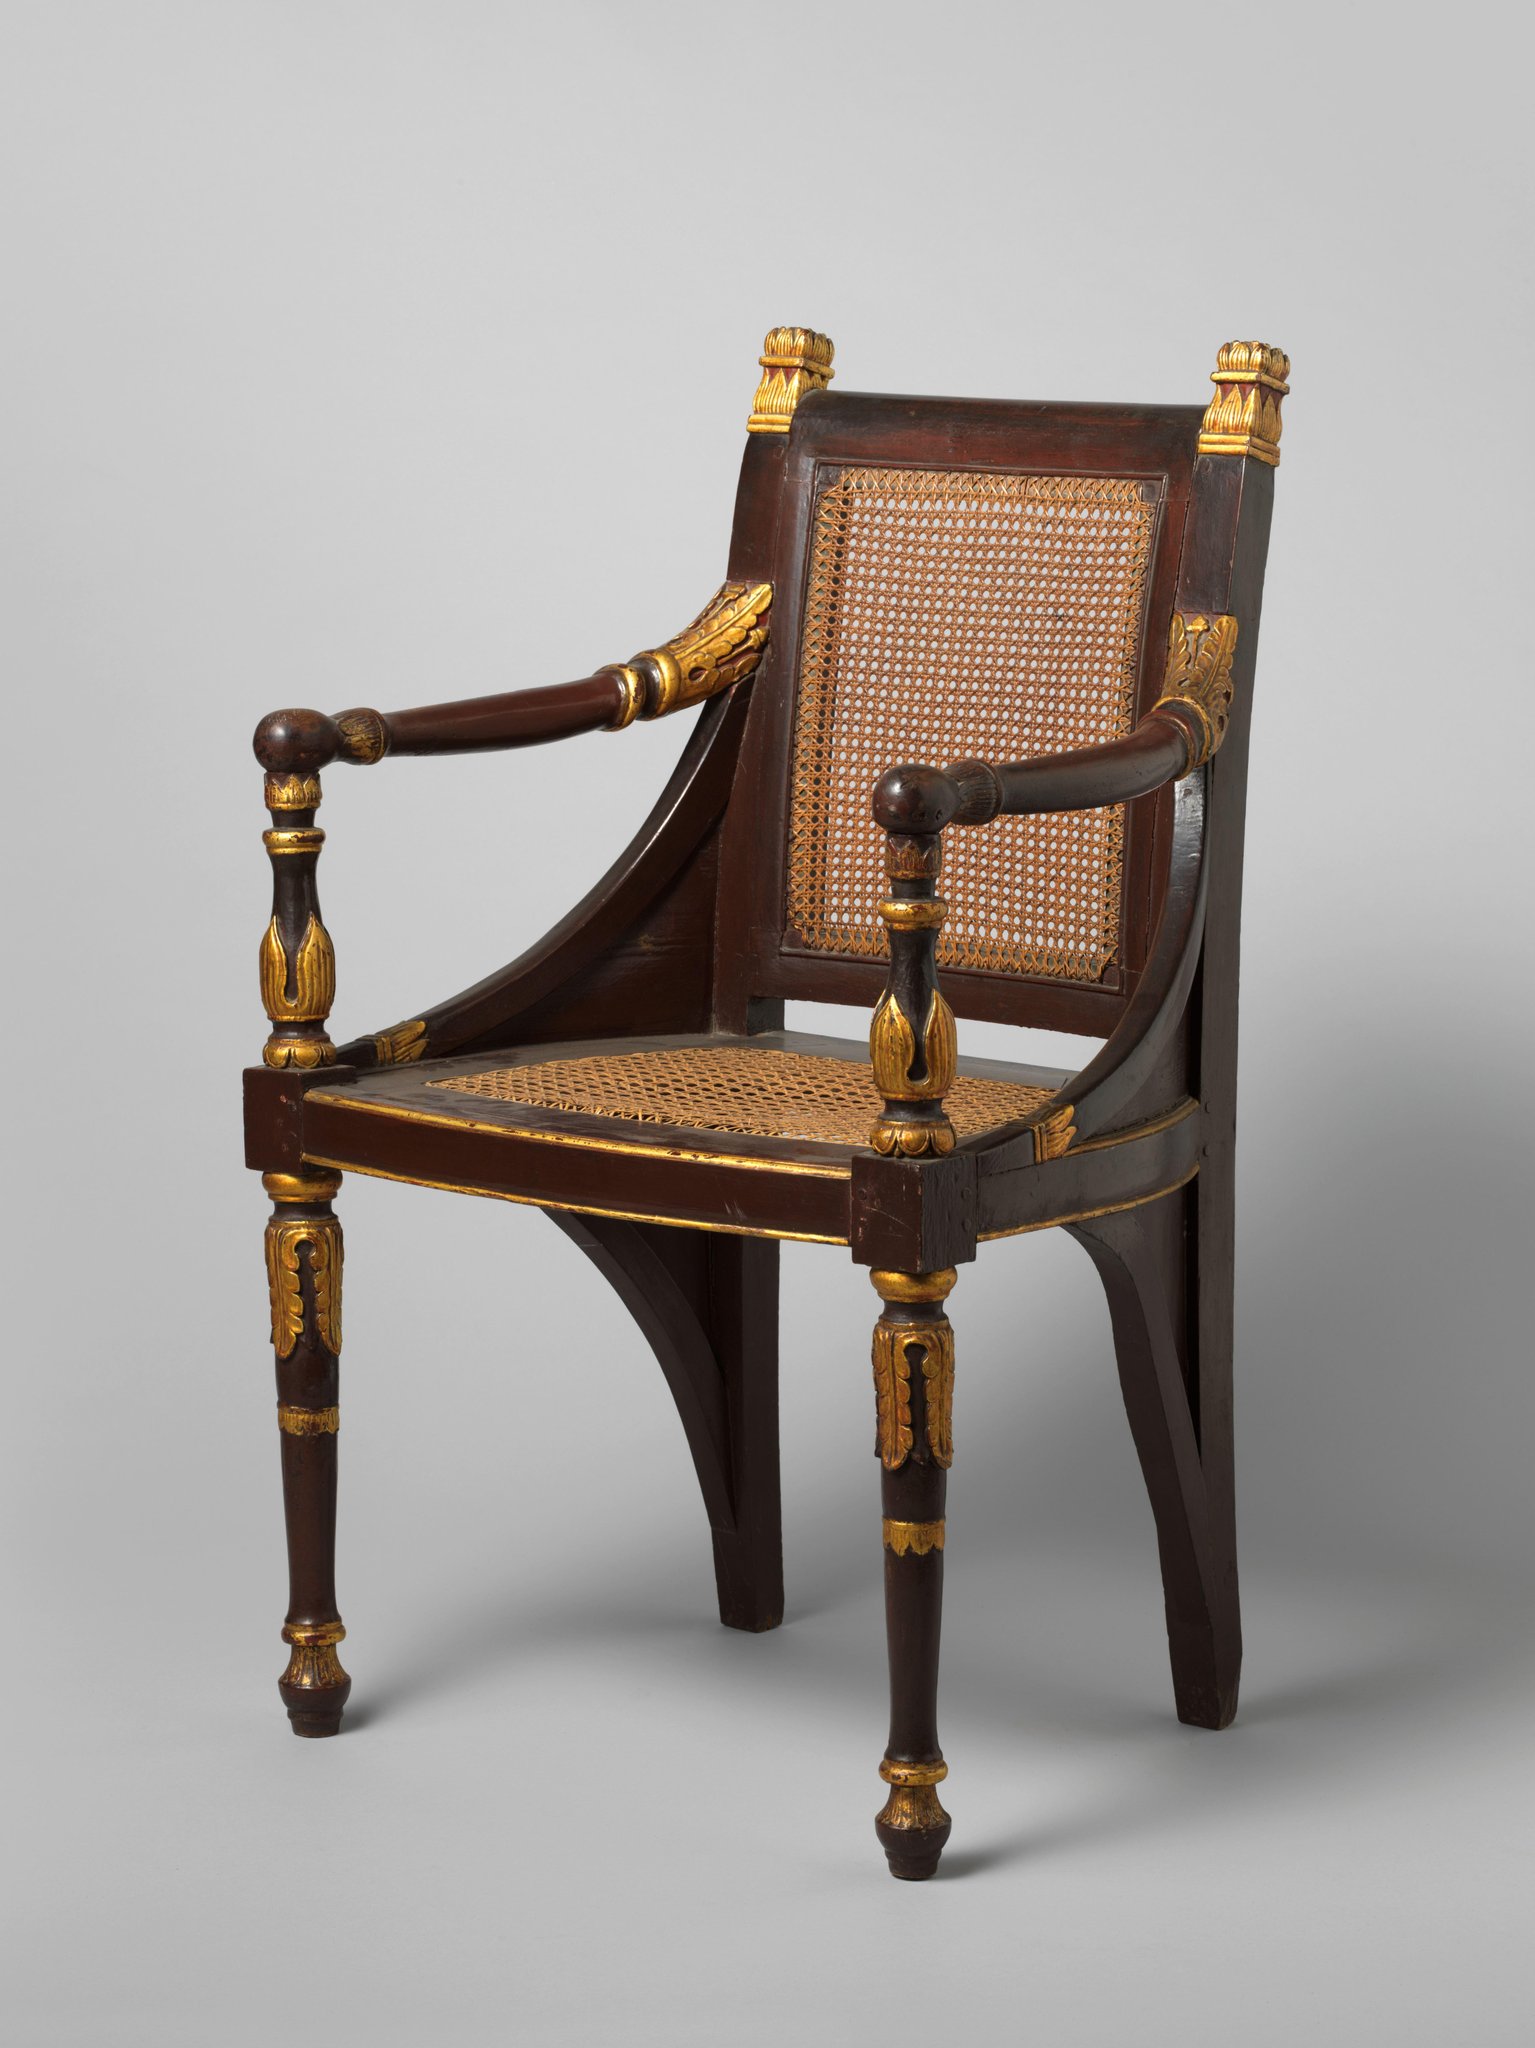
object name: furniture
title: Armstoel, Empire model, met rug en zitting van riet, rood geschilderd en met goud verguld en gehoogd.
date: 1800-1825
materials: wood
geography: indonesia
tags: batavia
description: Twee armstoelen (A en B) van een tropische houtsoort (djati?), rood geschilderd, onderdelen verguld en met goud gehoogd, de rug en het losse zitraam met riet bespannen. Empire-model met rechte, iets naar achteren gewelfde rug, zich verbredende zitting met gebogen zijden, balustervormige voorpoten en armstutten, gebogen, in bollen eindigende armen en dichte wangen met verdiepte velden, die onder de zitregel in spiegelbeeld en in kleiner formaat herhaald worden. Gebeeldhouwd met acanthus- en palmetmotieven die verguld zijn. Onderlinge verschillen in proporties en detaillering. Op beide etiket: 'Deze stoel heeft eens gestaan in het Kasteel Batavia. Later is hij in gebruik geweest bij het Hoogergerechtshof van Nederlandsch Indië Wagener'.